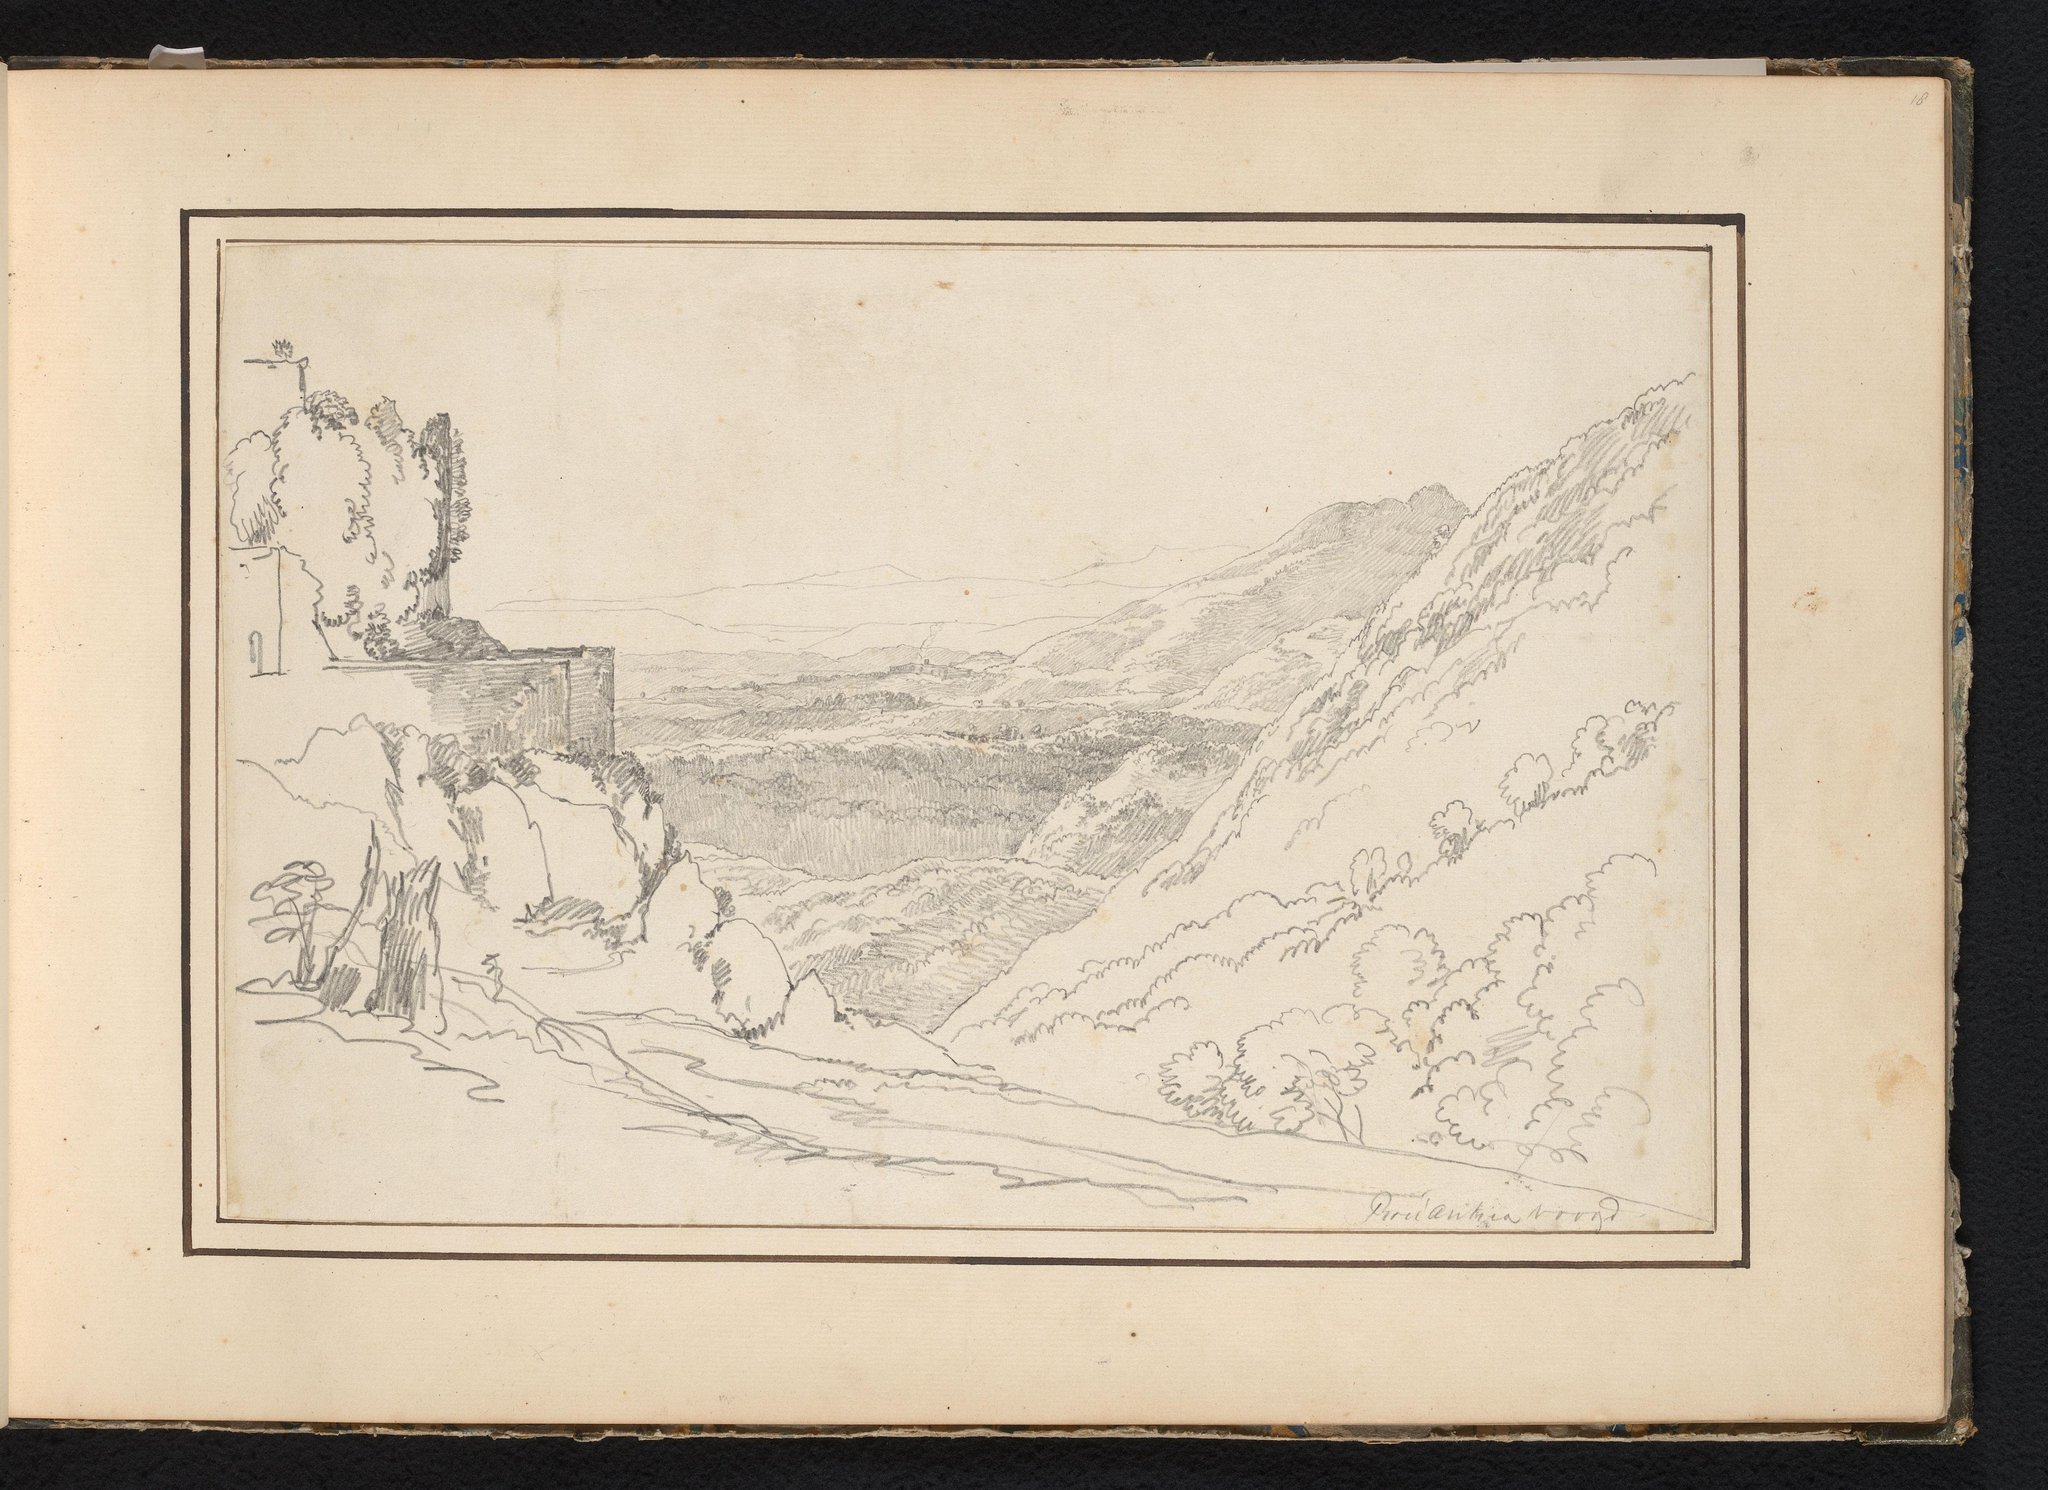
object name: album leaf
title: Vergezicht te Roccantica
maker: hendrik voogd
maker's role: draughtsman, painter, print maker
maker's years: 1768-1839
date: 1788-1839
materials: paper, pencil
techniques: pasting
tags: city-view, and landscape with man-made constructions, roccantica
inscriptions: inscription: ‘Rocc'antica’